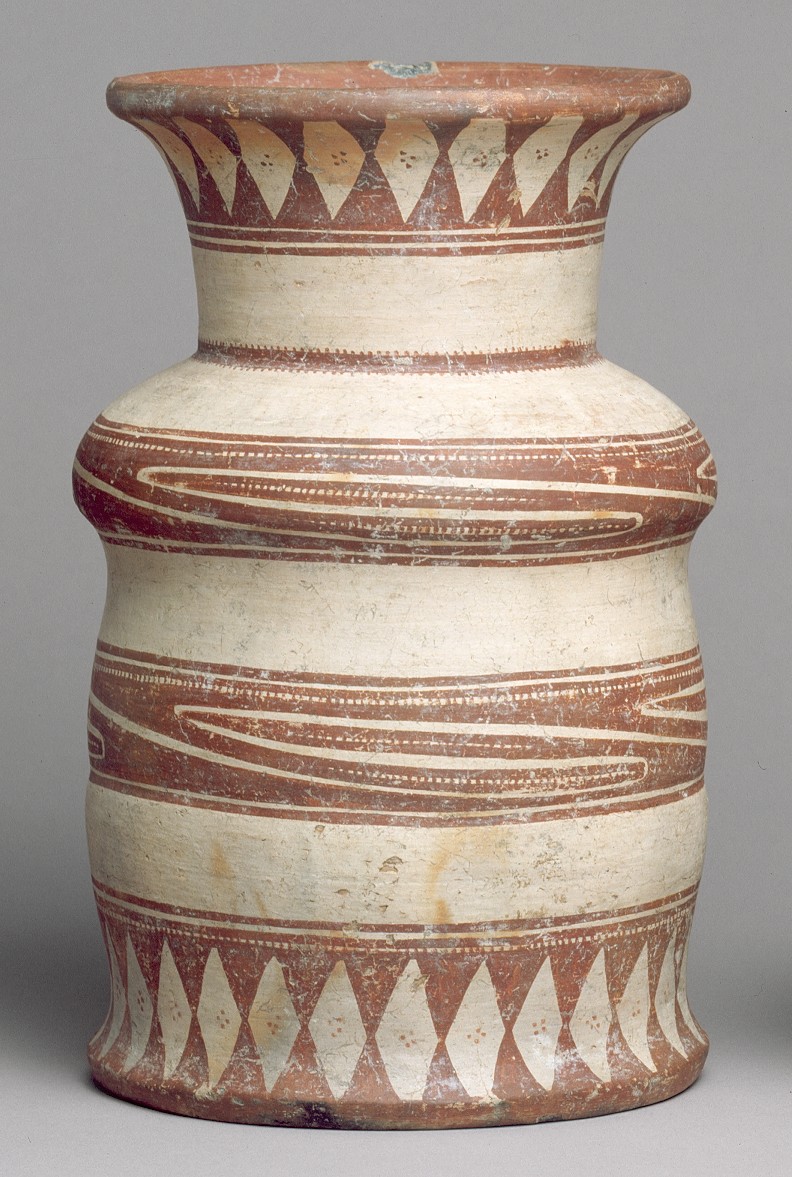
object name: jar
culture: thai, ban chiang culture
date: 300 BCE-200 CE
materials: earthenware